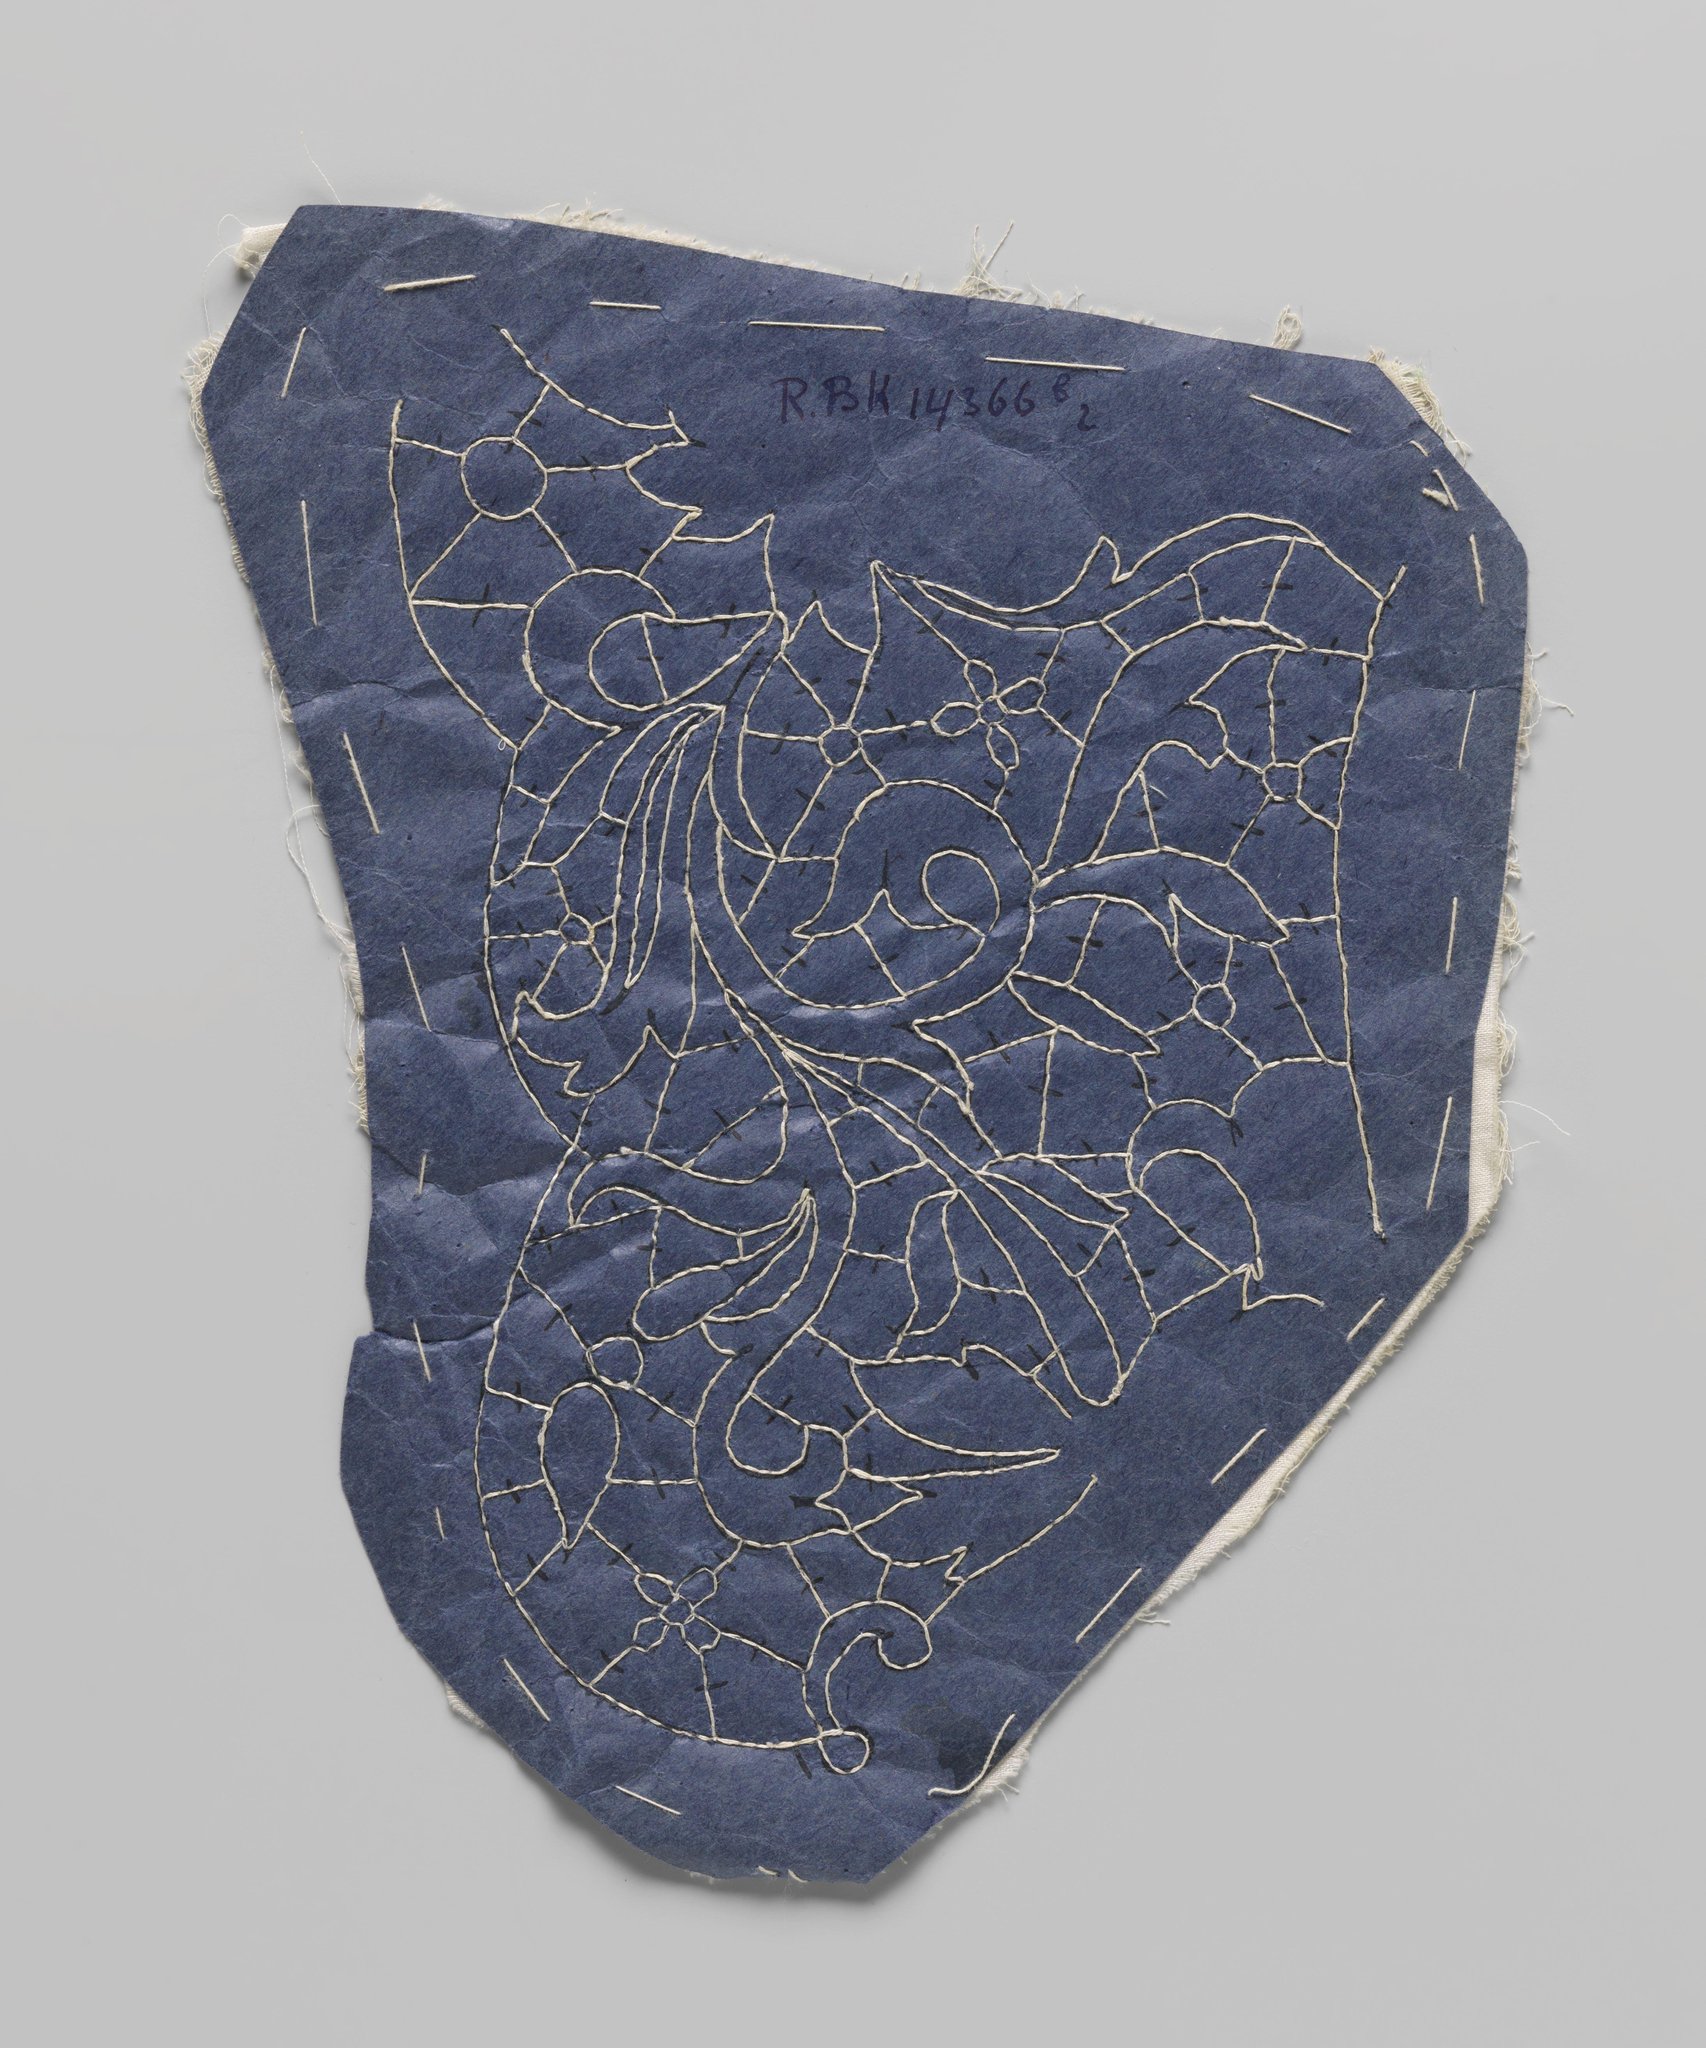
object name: lace pattern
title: Prikking vastgeregen op een dubbele lap katoen en met traceerdraden voor het maken van een deel van een kraag van naaldkant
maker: johanna e. van nierop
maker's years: 1882-1970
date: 1915-1924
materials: cotton, paper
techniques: sewing, needlepoint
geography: amersfoort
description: Prikking voor een deel van een kraag van Venetiaanse naaldkant. Het naaldkantpatroon is met inkt getekend op blauw papier en langs de patroonlijnen zijn vervolgens gaatjes geprikt. Door deze 'prikking' en de dubbele laag katoen is een traceerdraad genaaid. Als de naaldkantsteken over en tussen de traceerdraden gemaakt zijn kan de prikking en de katoenen ondergrond worden losgeknipt en verwijderd. Dan hou je alleen naaldkant over, in dit geval een deel van de kraag die dan met de andere delen en de rand tot kraag kan worden verwerkt. Het ontwerp van de kraag is gemaakt door een persoon uit België die in de Eerste Wereldoorlog was geïnterneerd in kamp 'Elisabeth-dorp' in Amersfoort. Mevrouw van Nierop is begonnen met het maken van de kraag en heeft de onafgewerkte delen geschonken aan het Rijksmuseum als studiemateriaal.